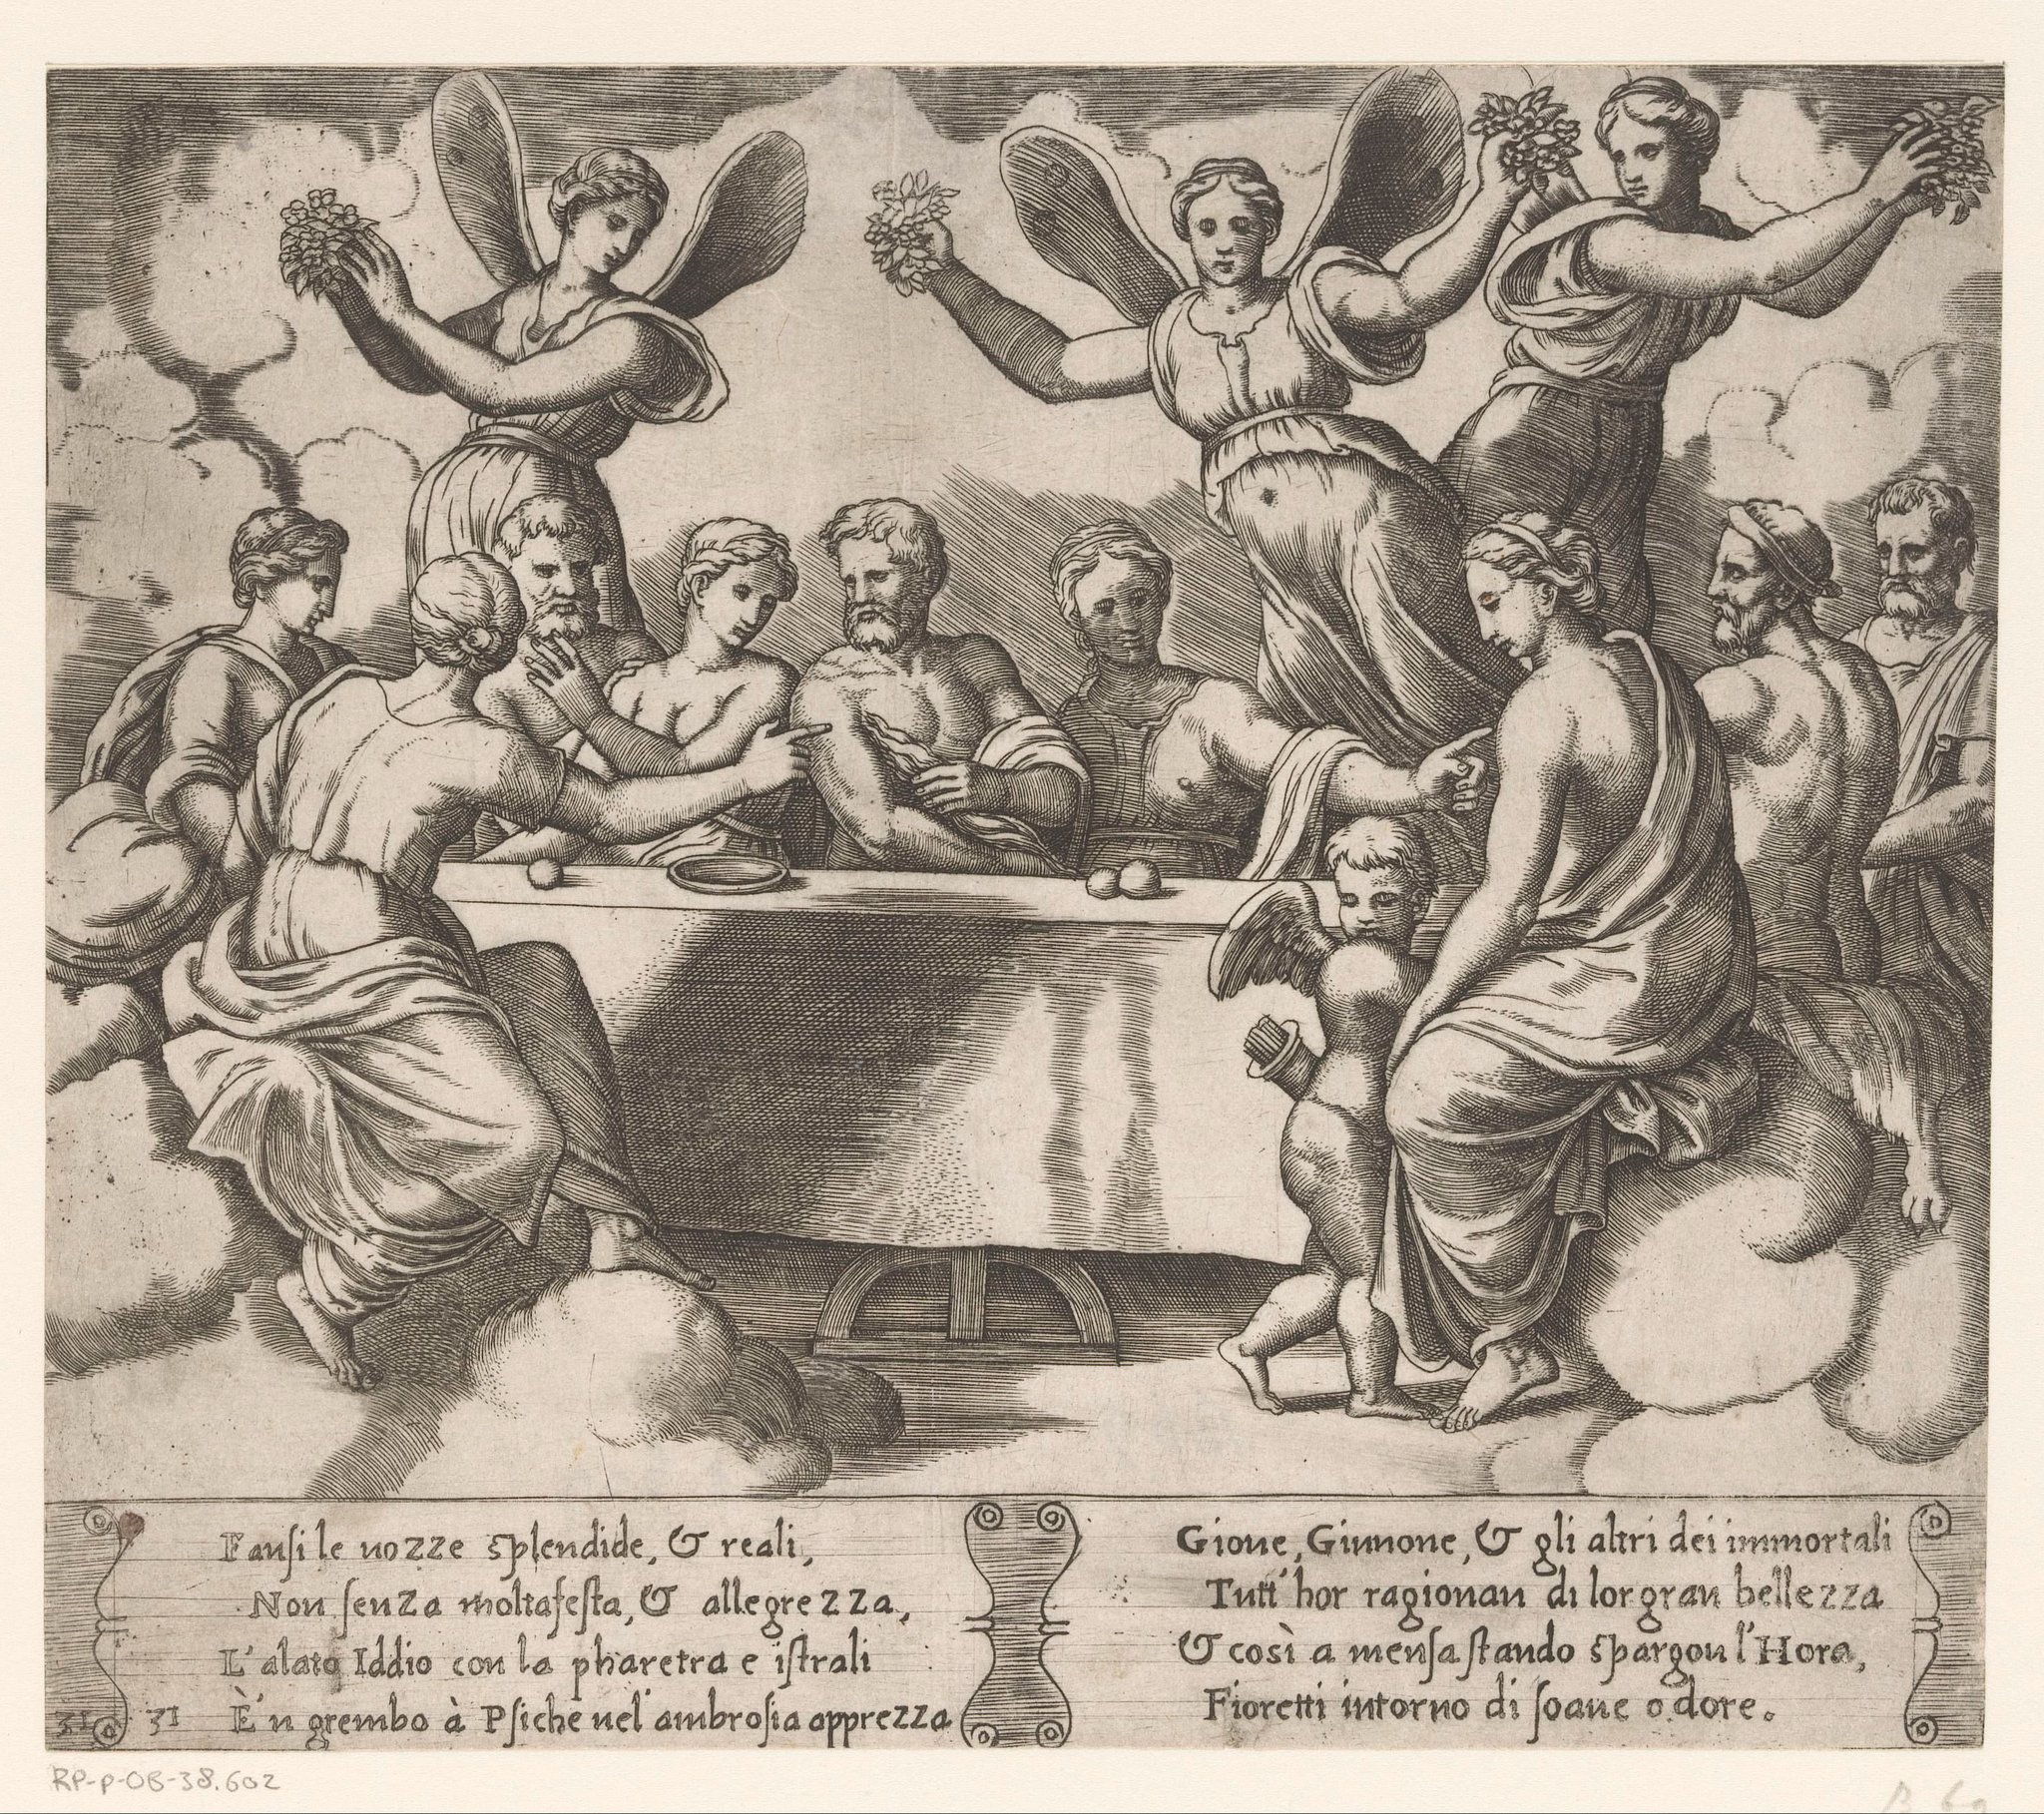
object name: print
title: Bruiloft van Amor en Psyche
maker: meester van de dobbelsteen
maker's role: print maker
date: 1530-1560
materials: paper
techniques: engraving, intaglio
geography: italy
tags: (story of) hercules (heracles), marriage of cupid and psyche, hours (horae), seasons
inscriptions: collector's mark: Lugt 2228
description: Banket tijdens de bruiloft van Amor en Psyche. Rondom een lange tafel zitten Amor en Psyche met een aantal andere goden. Rechts zit Hercules op zijn leeuwenvel. Achter de tafel drie Horae (godinnen van de jaargetijden) met vlindervleugels. Italiaanse tekst in twee cartouches in ondermarge. Tweemaal genummerd linksonder: 31.